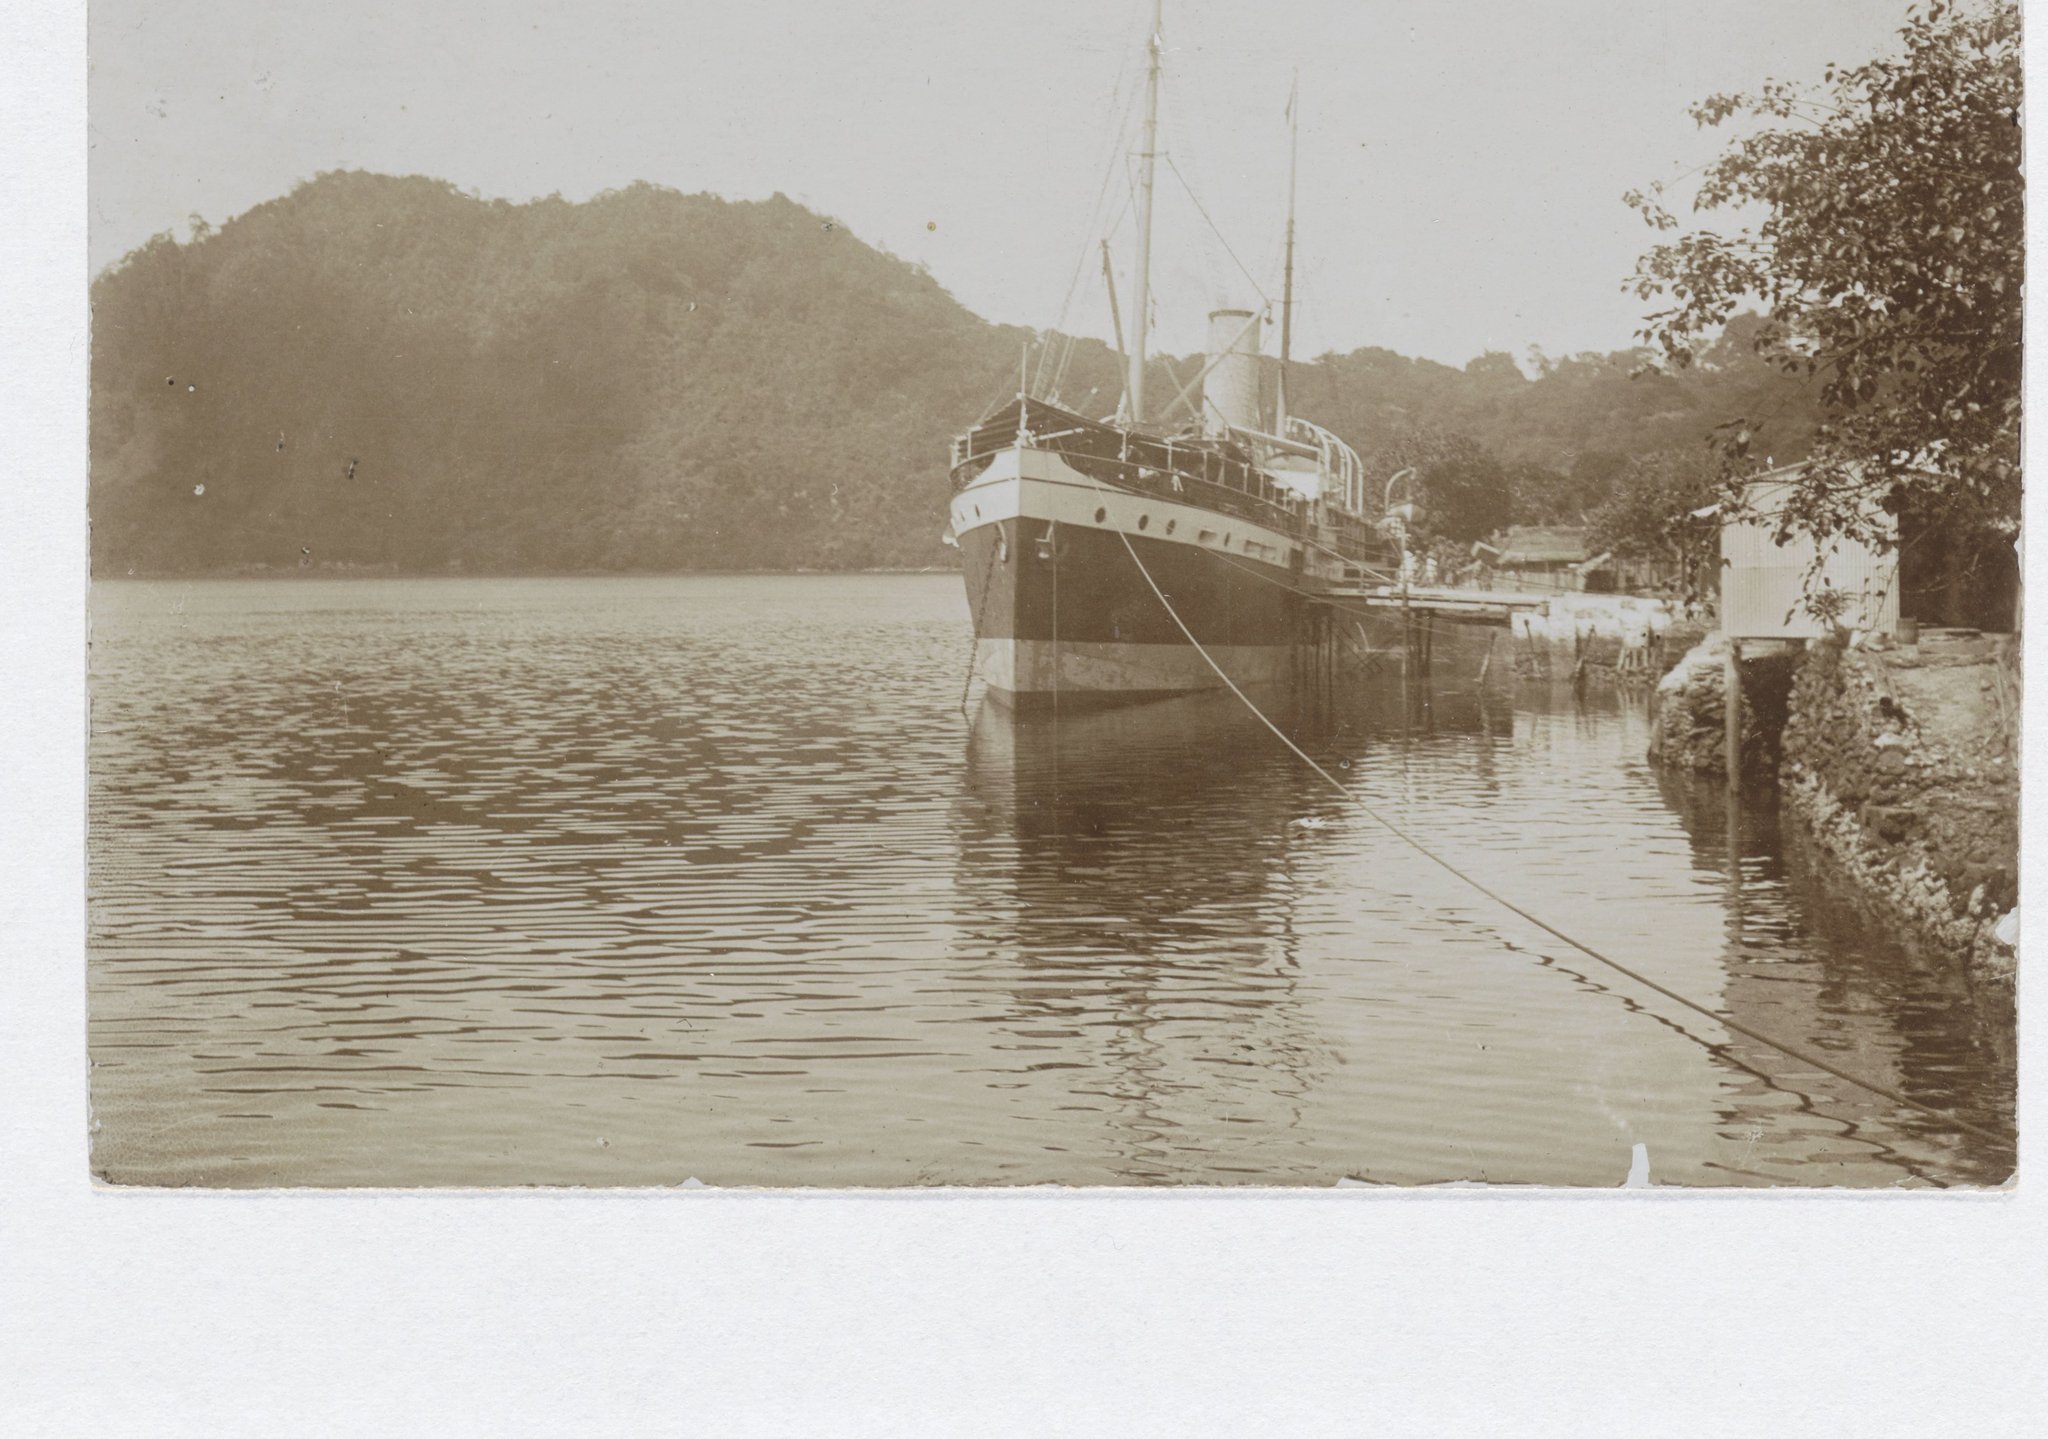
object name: photograph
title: Een aangemeerde grote stoomboot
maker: johanna hermina marmelstein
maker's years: 1897-1990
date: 1900-1915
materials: paper, photographic support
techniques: albumen print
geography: jakarta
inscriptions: number: ‘r. 171’